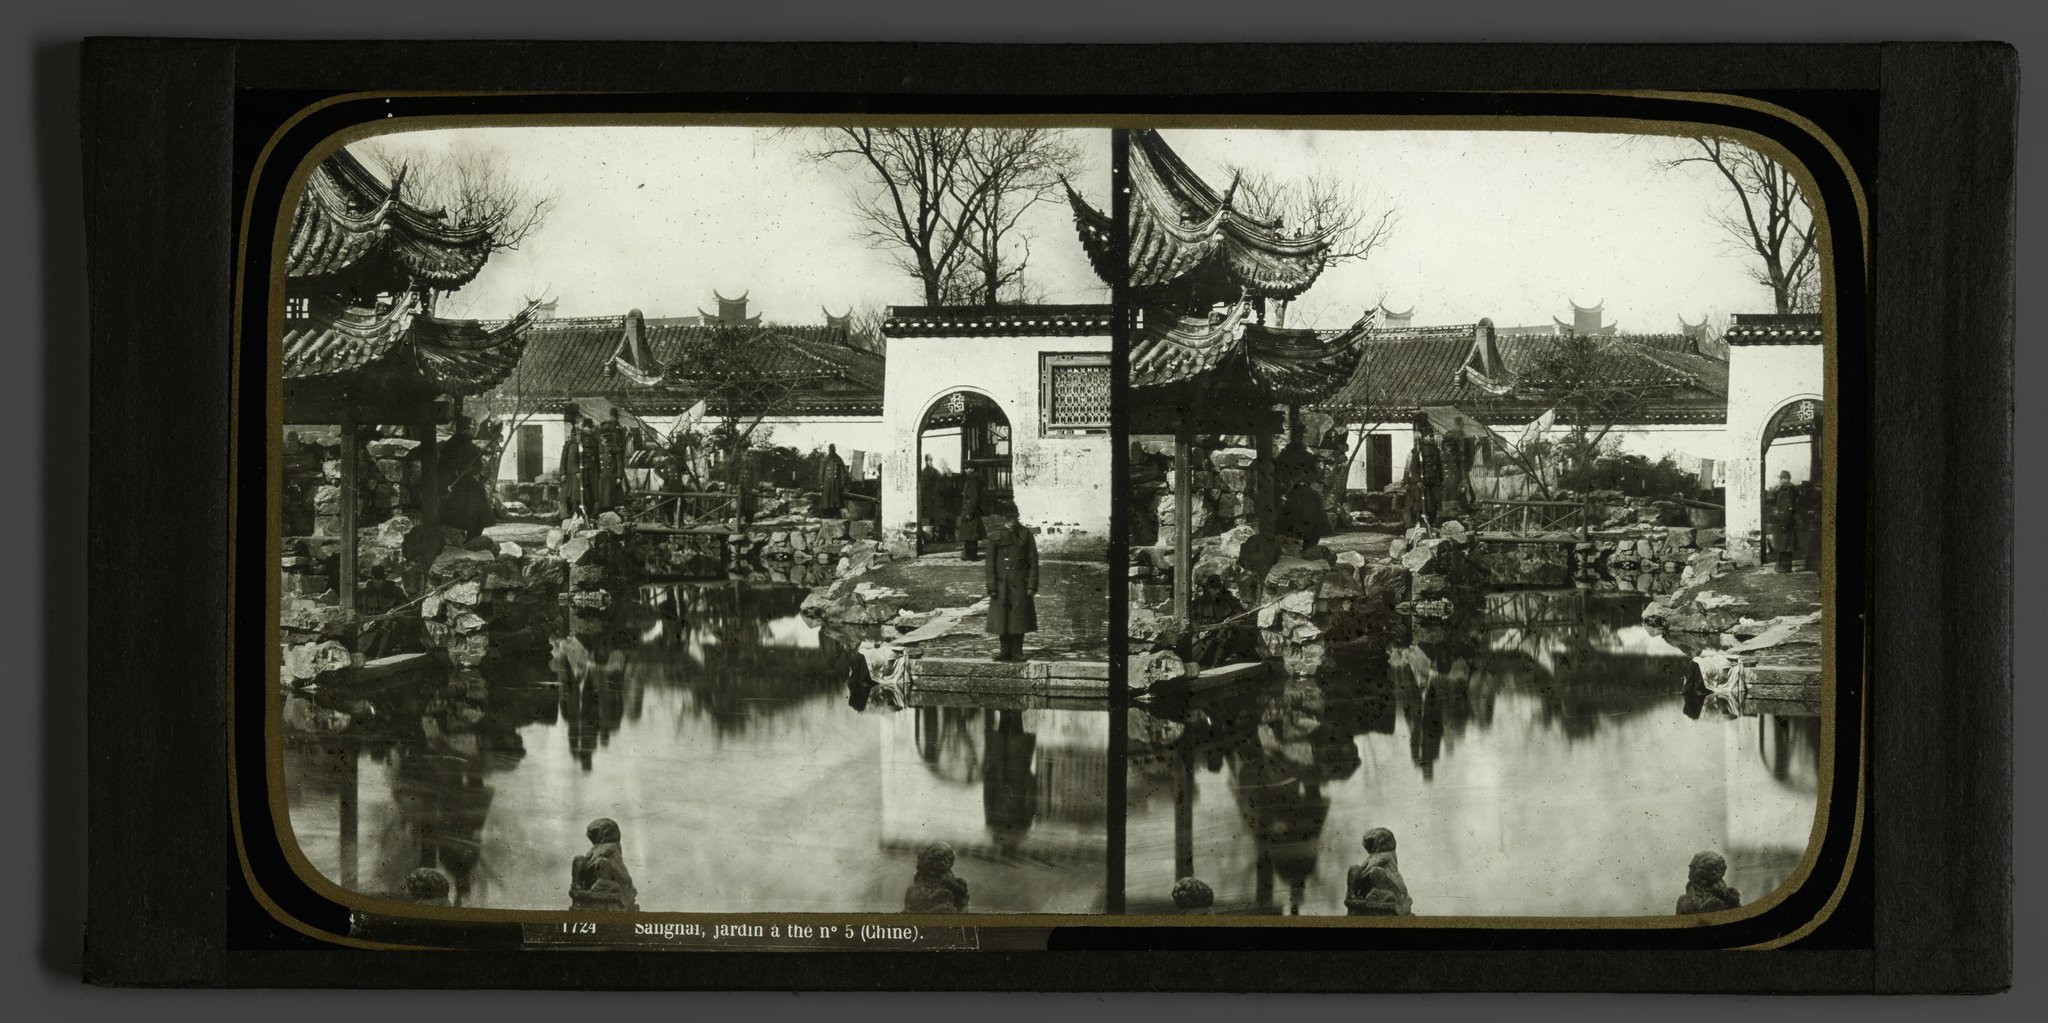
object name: stereoscopic photograph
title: Gezicht op een theetuin in Shanghai, China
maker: Anonymous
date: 1860-1890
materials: glass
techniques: slide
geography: shanghai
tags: garden buildings, garden pond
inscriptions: number: ‘1724’